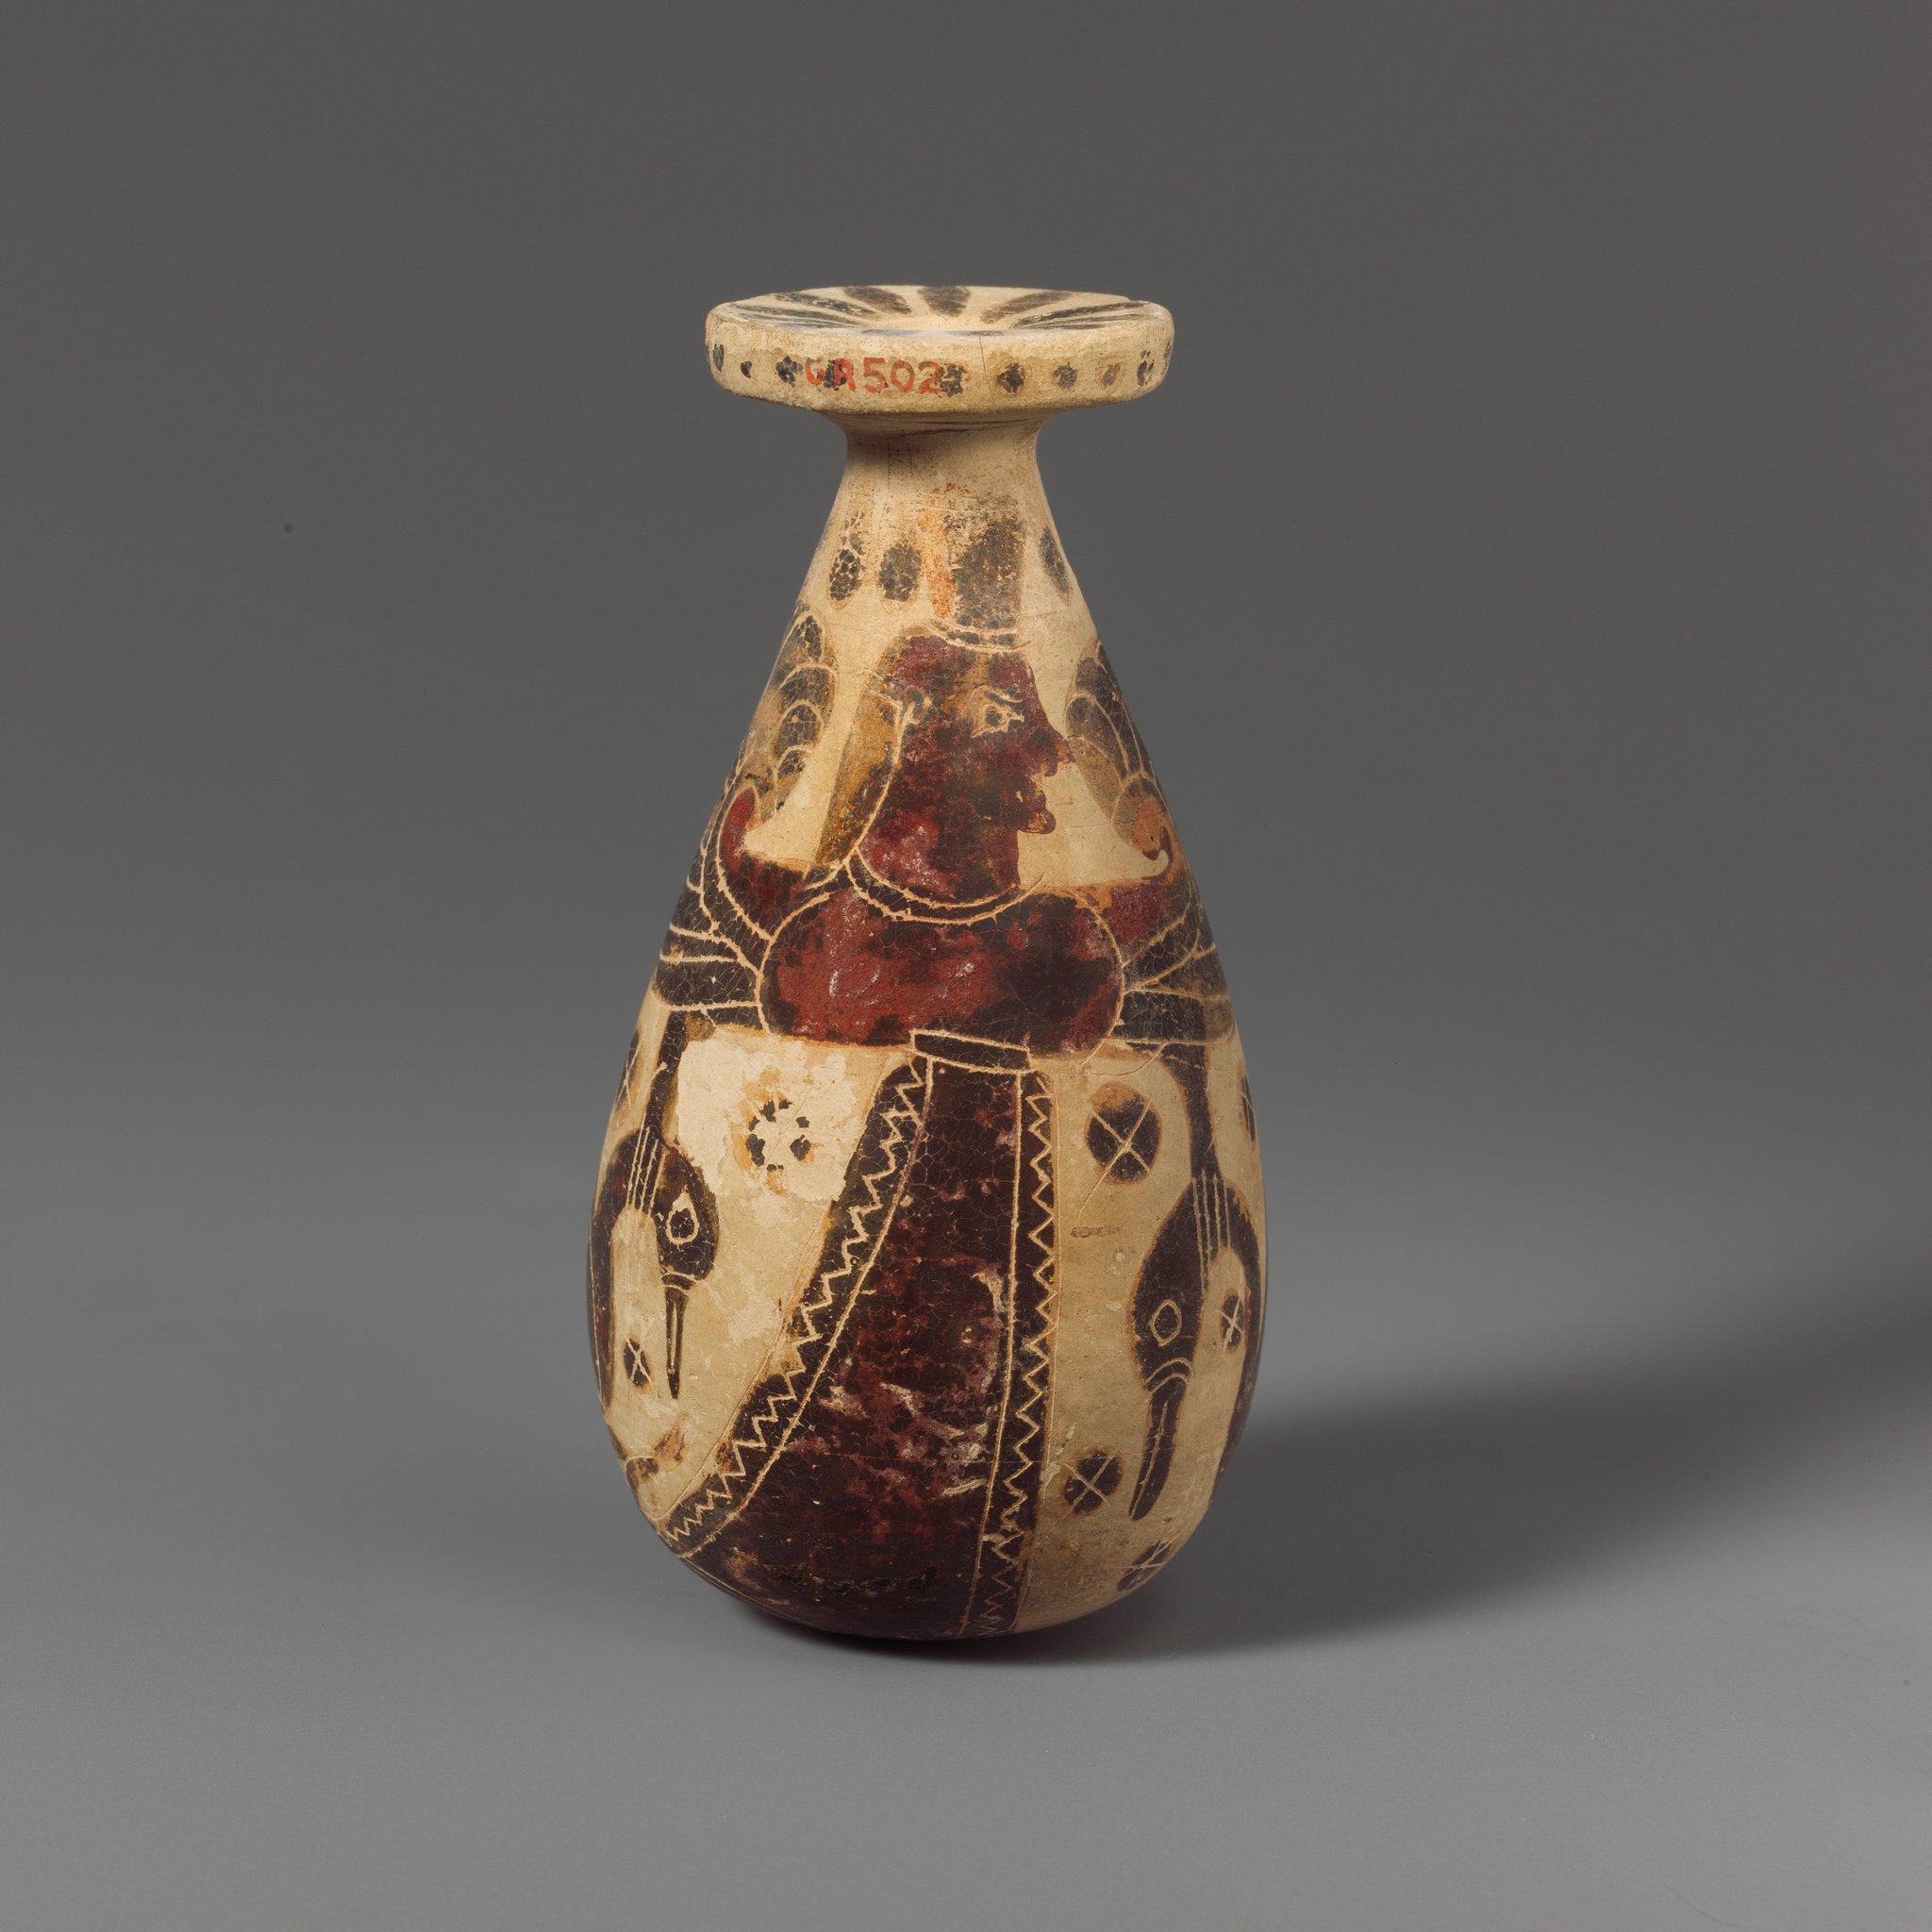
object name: alabastron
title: Terracotta alabastron (perfume vase)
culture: greek, corinthian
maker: potnia painter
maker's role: artist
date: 620-590 BCE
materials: terracotta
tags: animals,swans